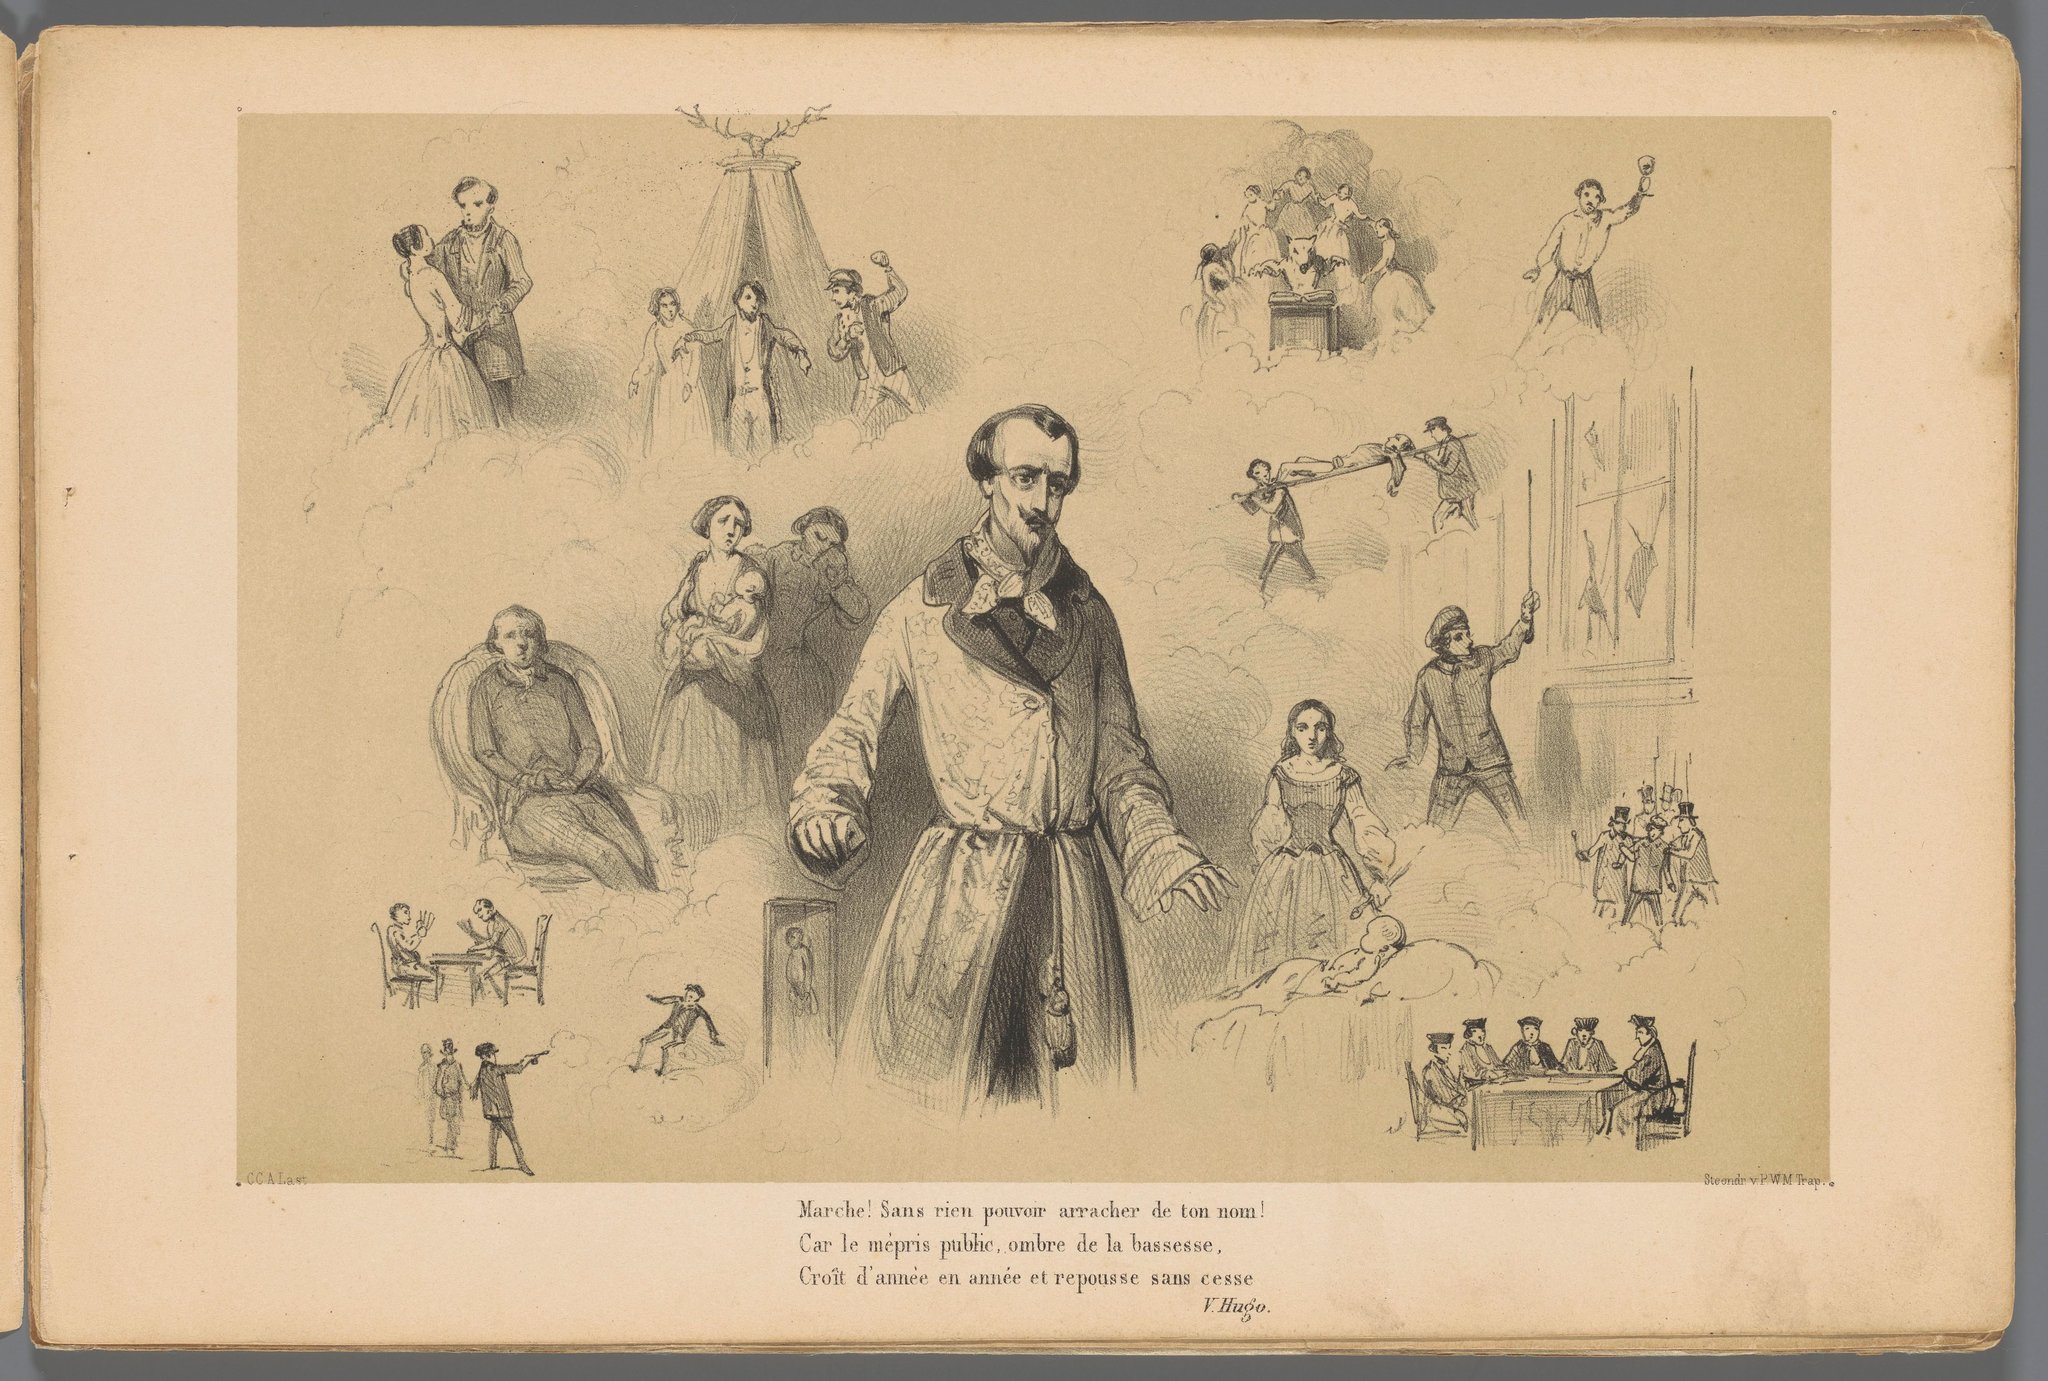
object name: print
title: Tien jaren later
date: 1836-1876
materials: paper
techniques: tone lithography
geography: leiden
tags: bath-robe, dressing-gown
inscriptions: collector's mark: Lugt 2228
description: De serie met omslag werd samengesteld door Jan van der Hoeven (Leiden 1834 - Rotterdam 1900). Van der Hoeven was mede oprichter van het Sophia-Kinderziekenhuis in Rotterdam en was als heelmeester verbonden aan het stedelijk ziekenhuis aldaar.